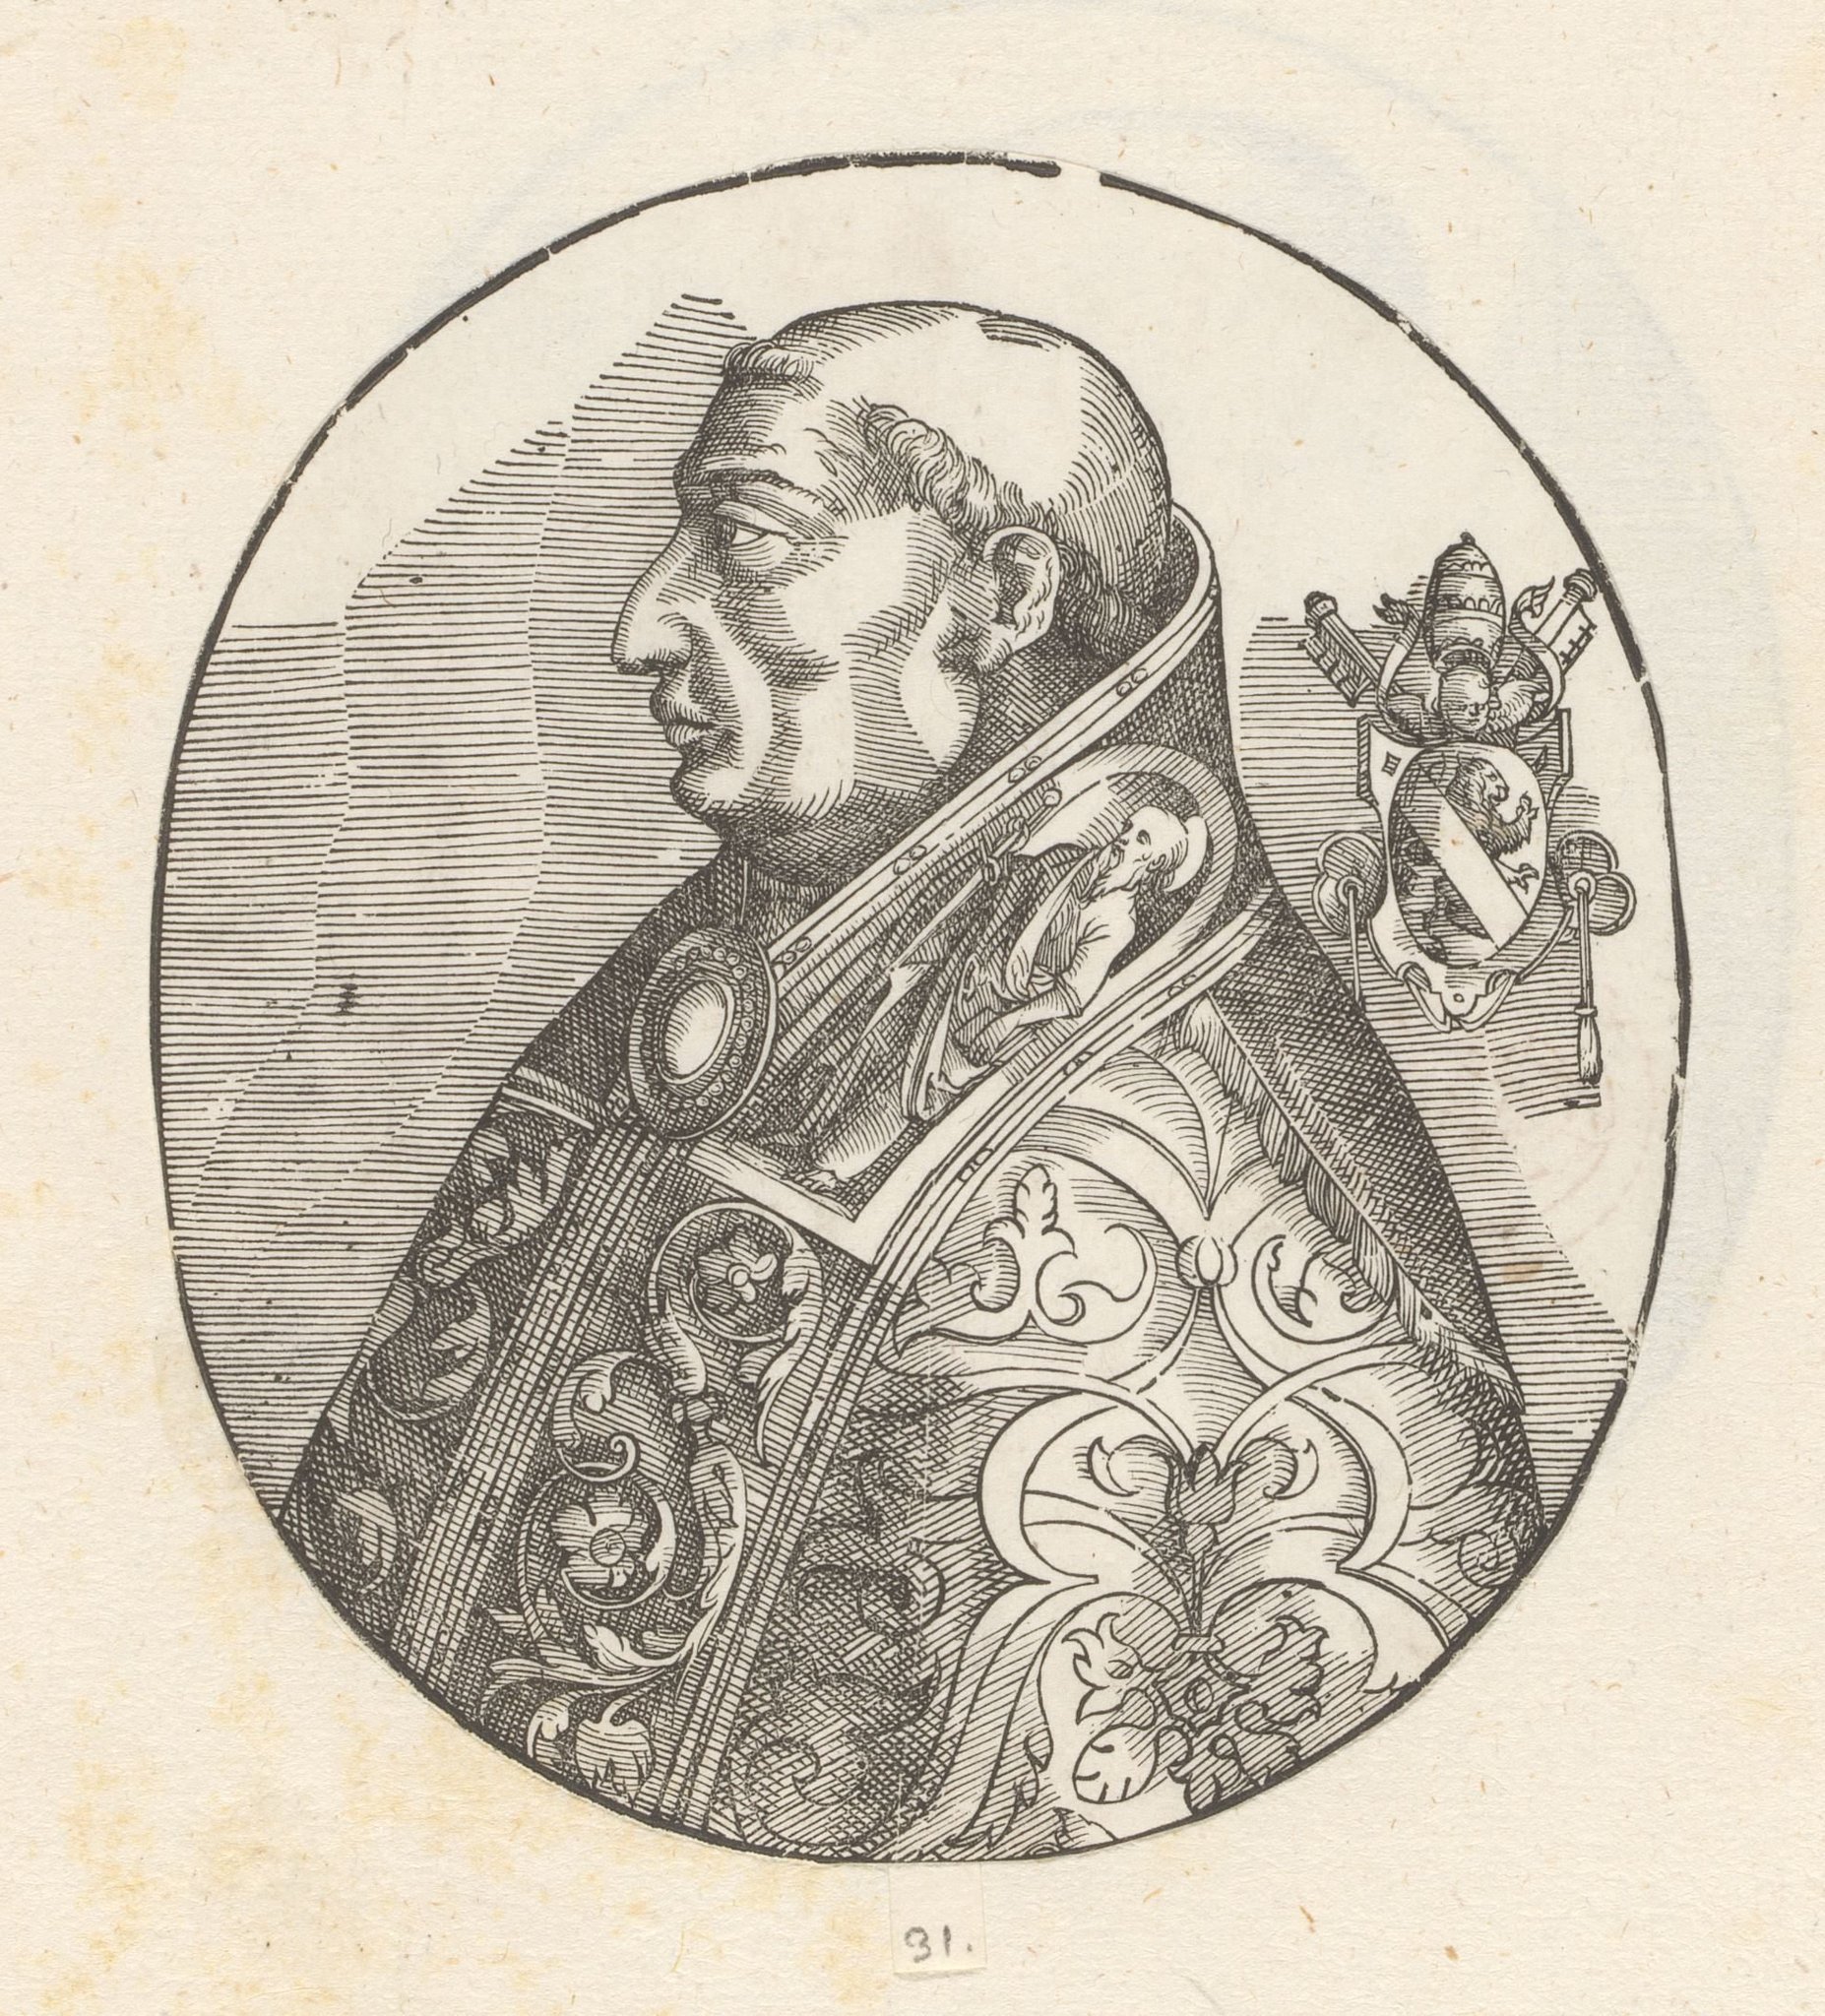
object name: print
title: Portret van paus Paulus II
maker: Anonymous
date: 1549-1573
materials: paper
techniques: woodcut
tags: rome, historical persons, pope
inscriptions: collector's mark: Lugt 240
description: Prent gebruikt in: Panvinio, Onofrio. Accuratae Effigies Pontificum (...). Straatsburg: Bernhard Jobin, 1573.